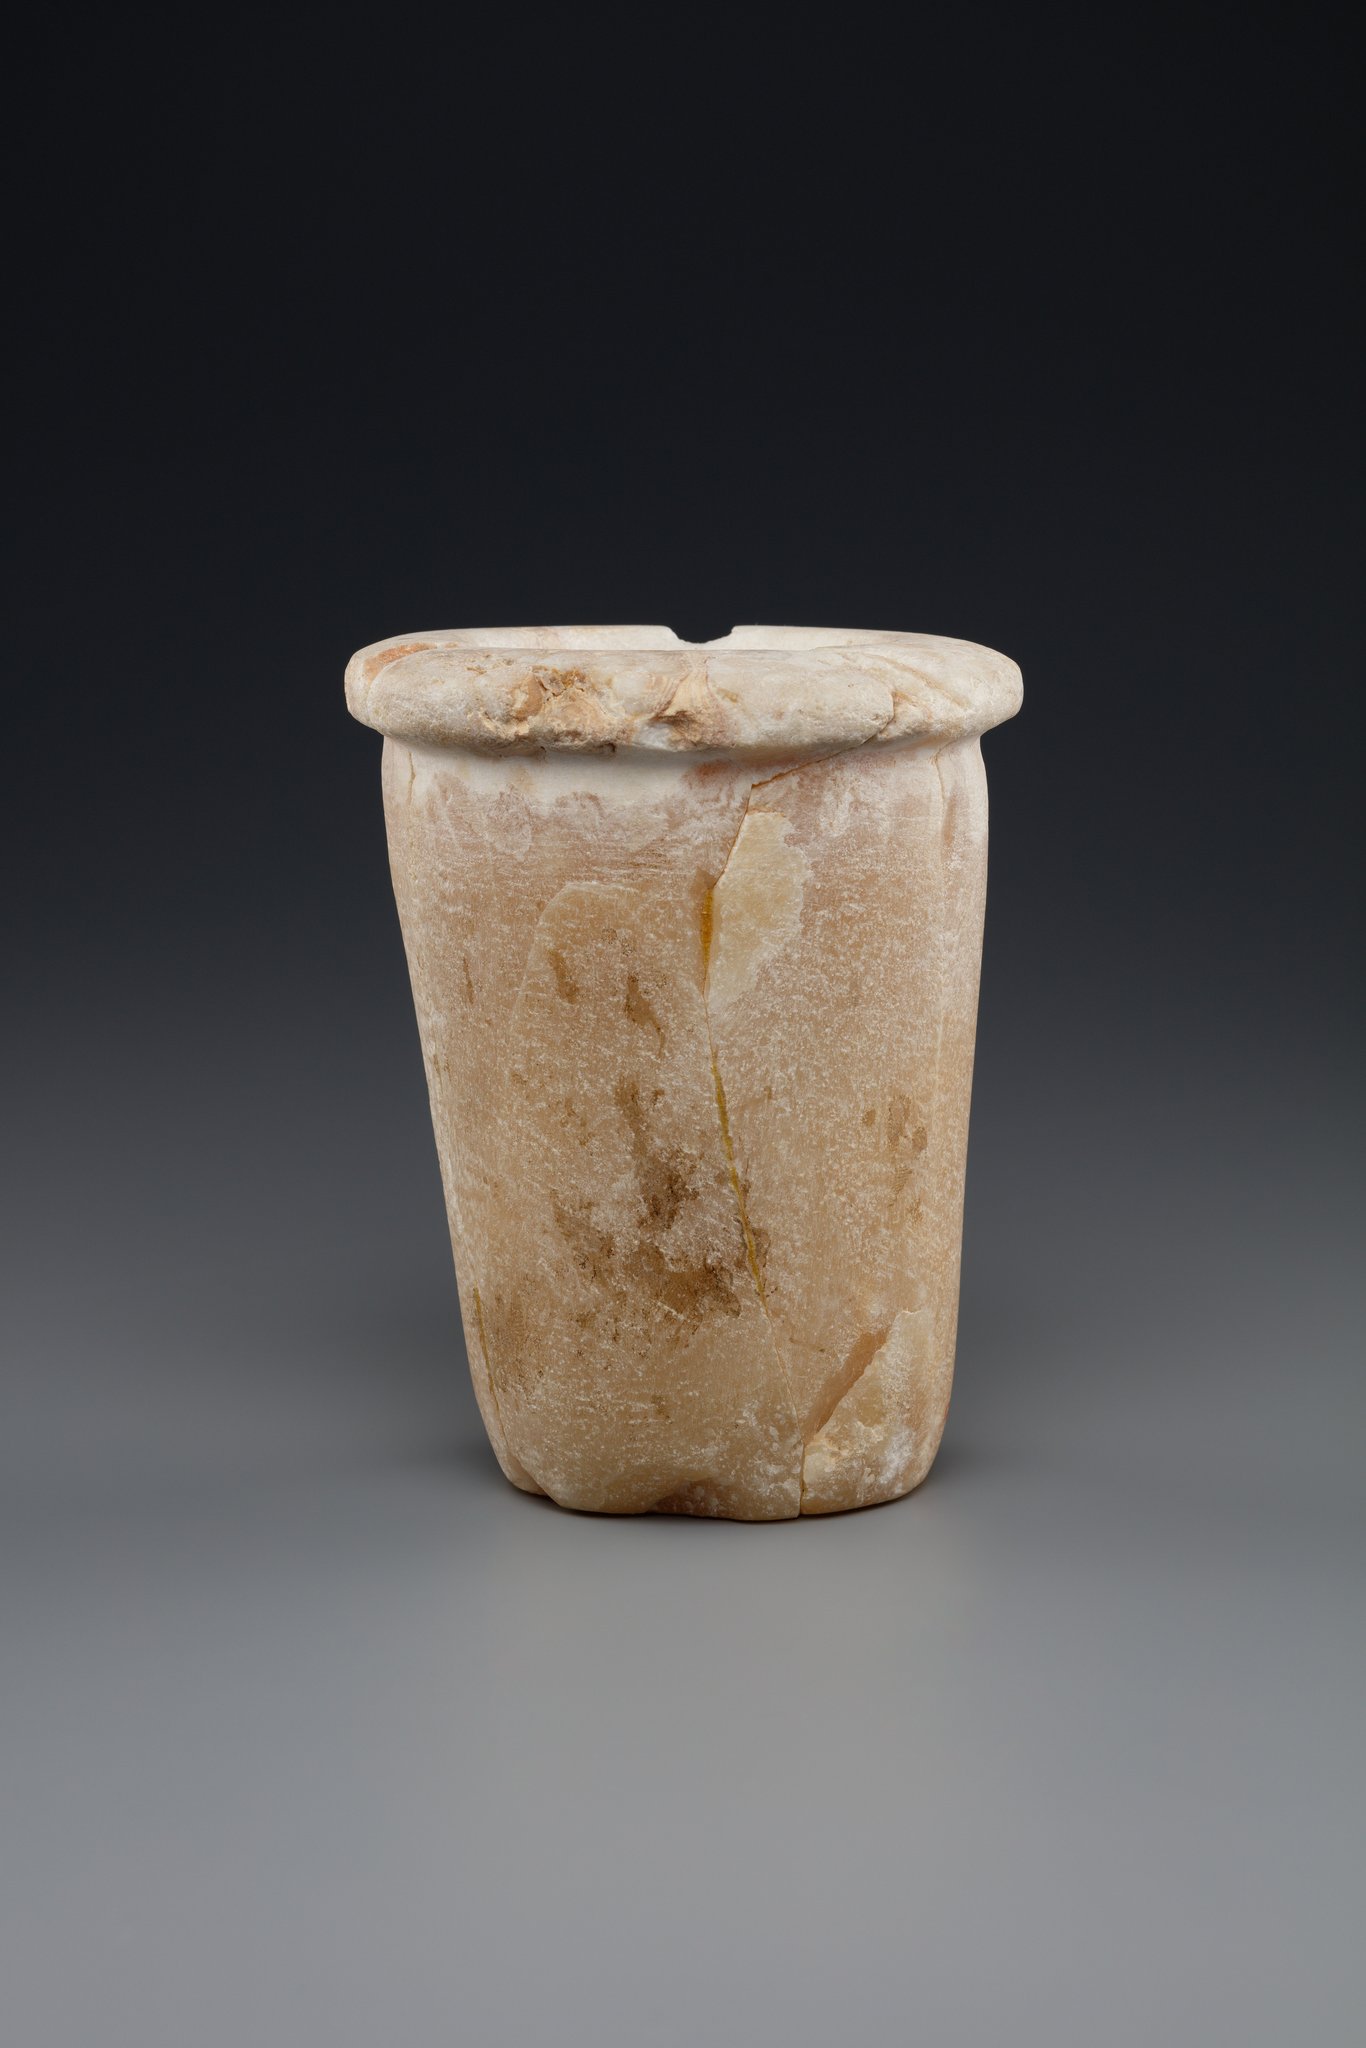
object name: jar, cylindrical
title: Cylinder jar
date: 3100-2649 BCE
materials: stone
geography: egypt